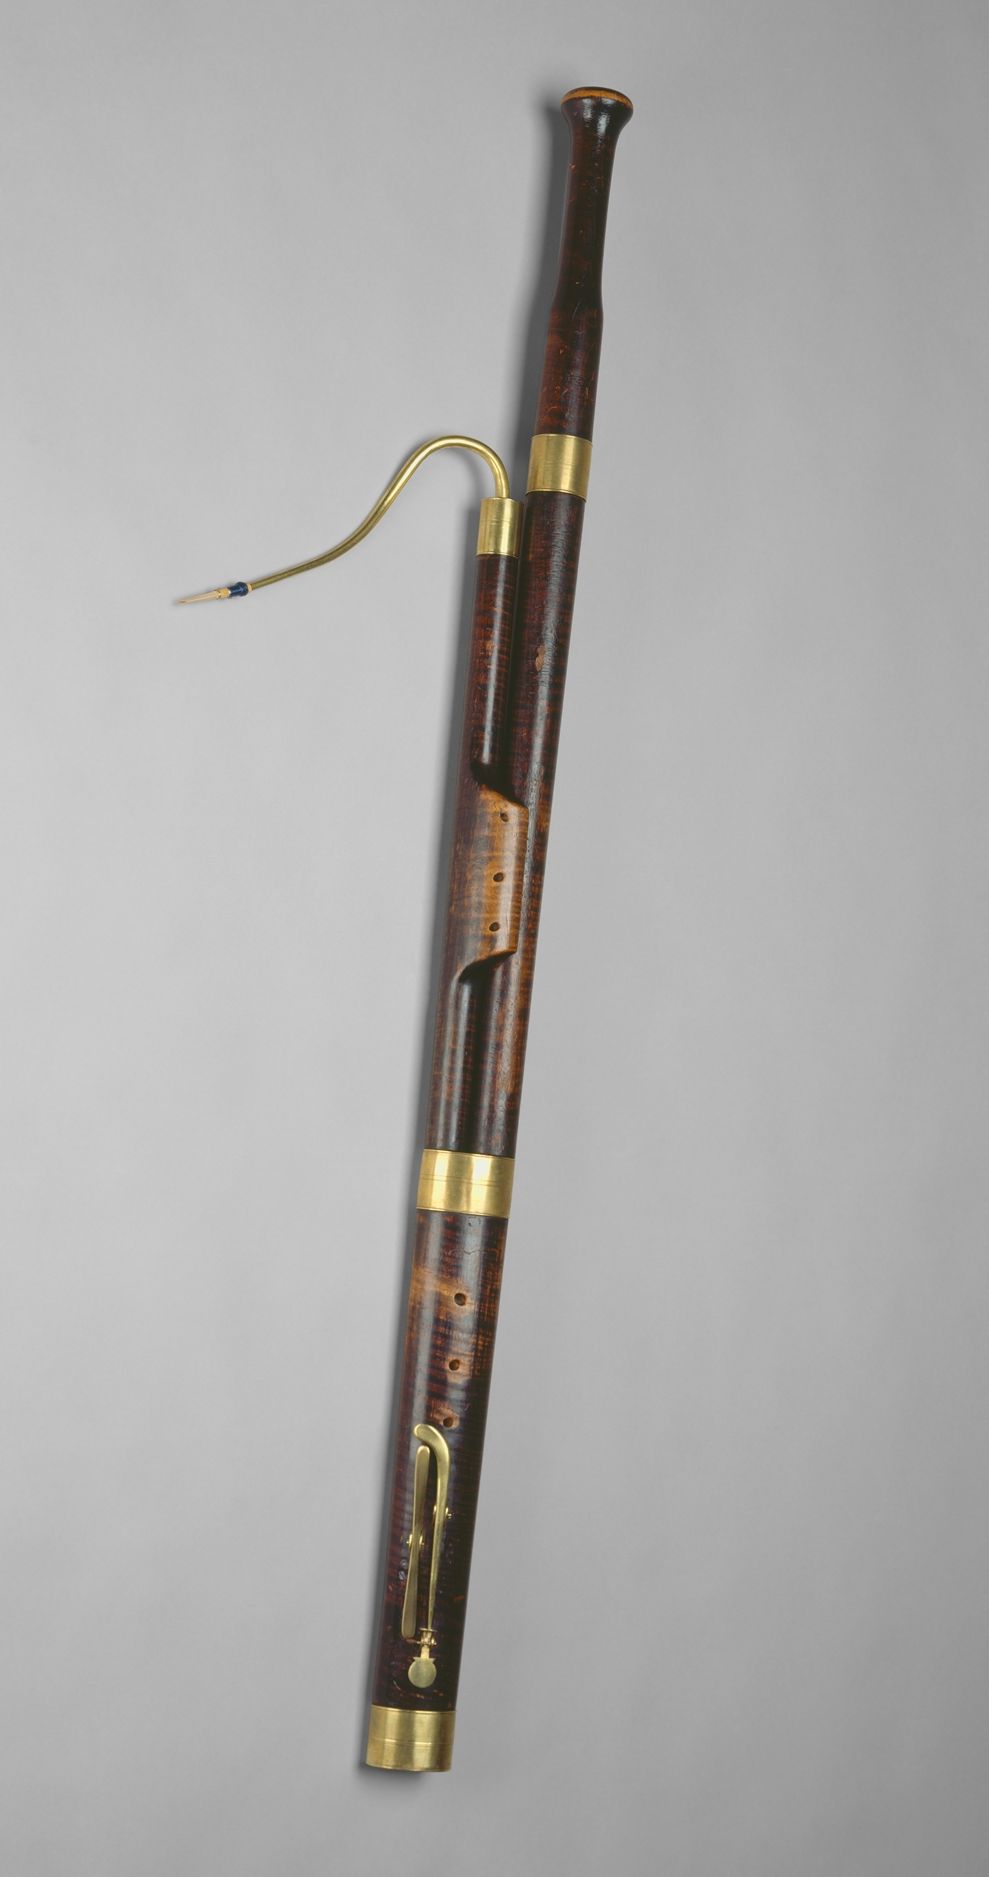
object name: bassoon in c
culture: american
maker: john meacham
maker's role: maker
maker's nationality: american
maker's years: 1785-1844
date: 1811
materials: brass, wood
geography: united states